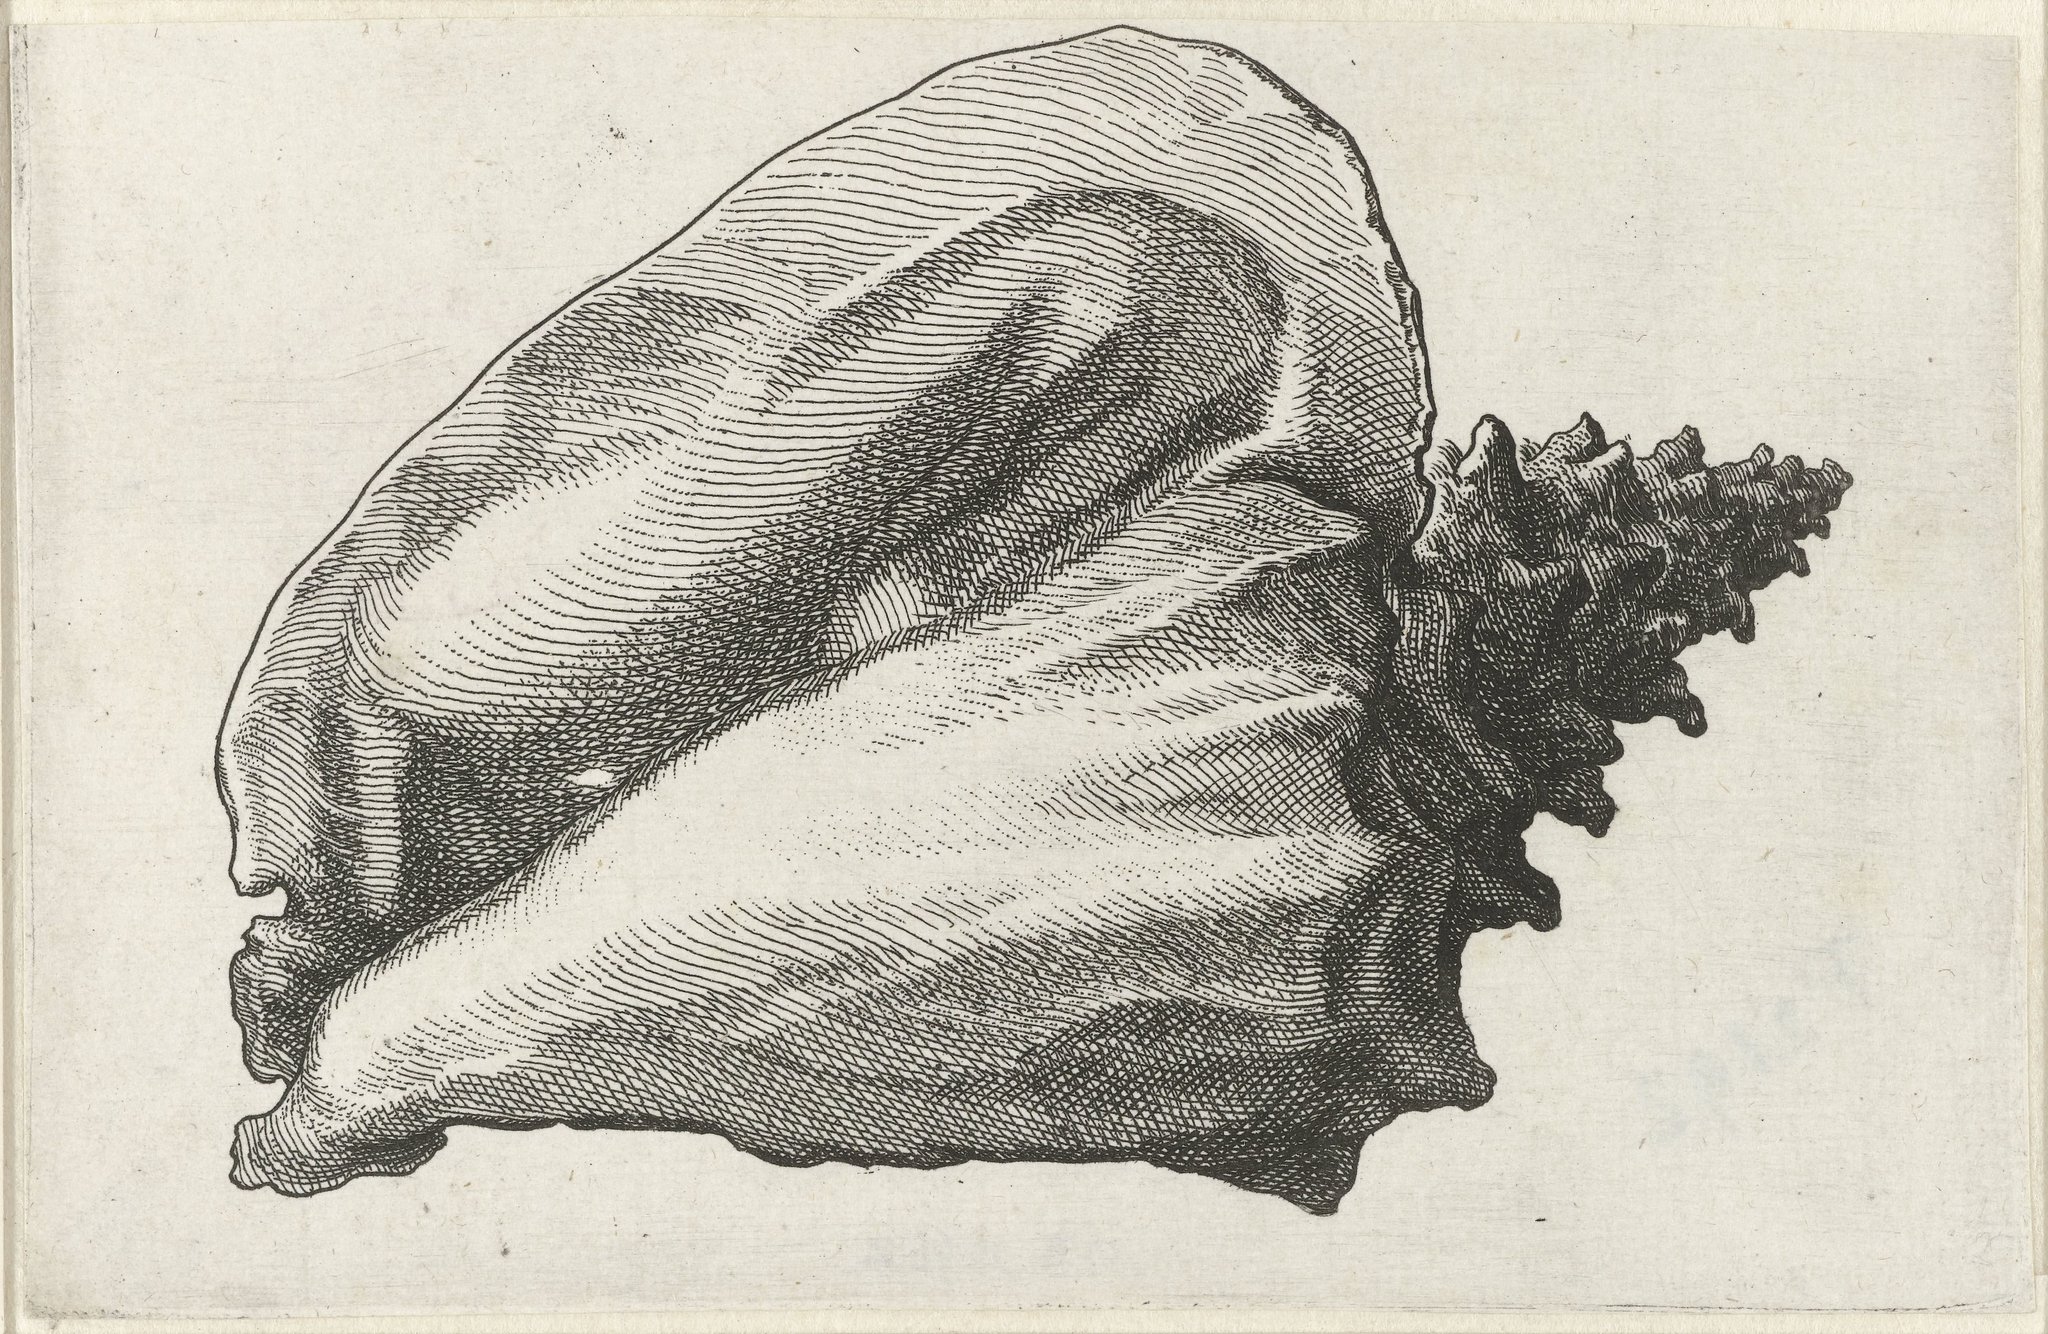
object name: print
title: Schelpen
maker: wenceslaus hollar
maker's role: draughtsman, print maker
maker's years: 1607-1677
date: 1644-1652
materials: paper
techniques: etching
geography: antwerp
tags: molluscs (+ shell, snail-shell etc.)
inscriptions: collector's mark: Lugt 240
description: Prent maakt deel uit van een 39-delige serie met verschillende soorten schelpen.